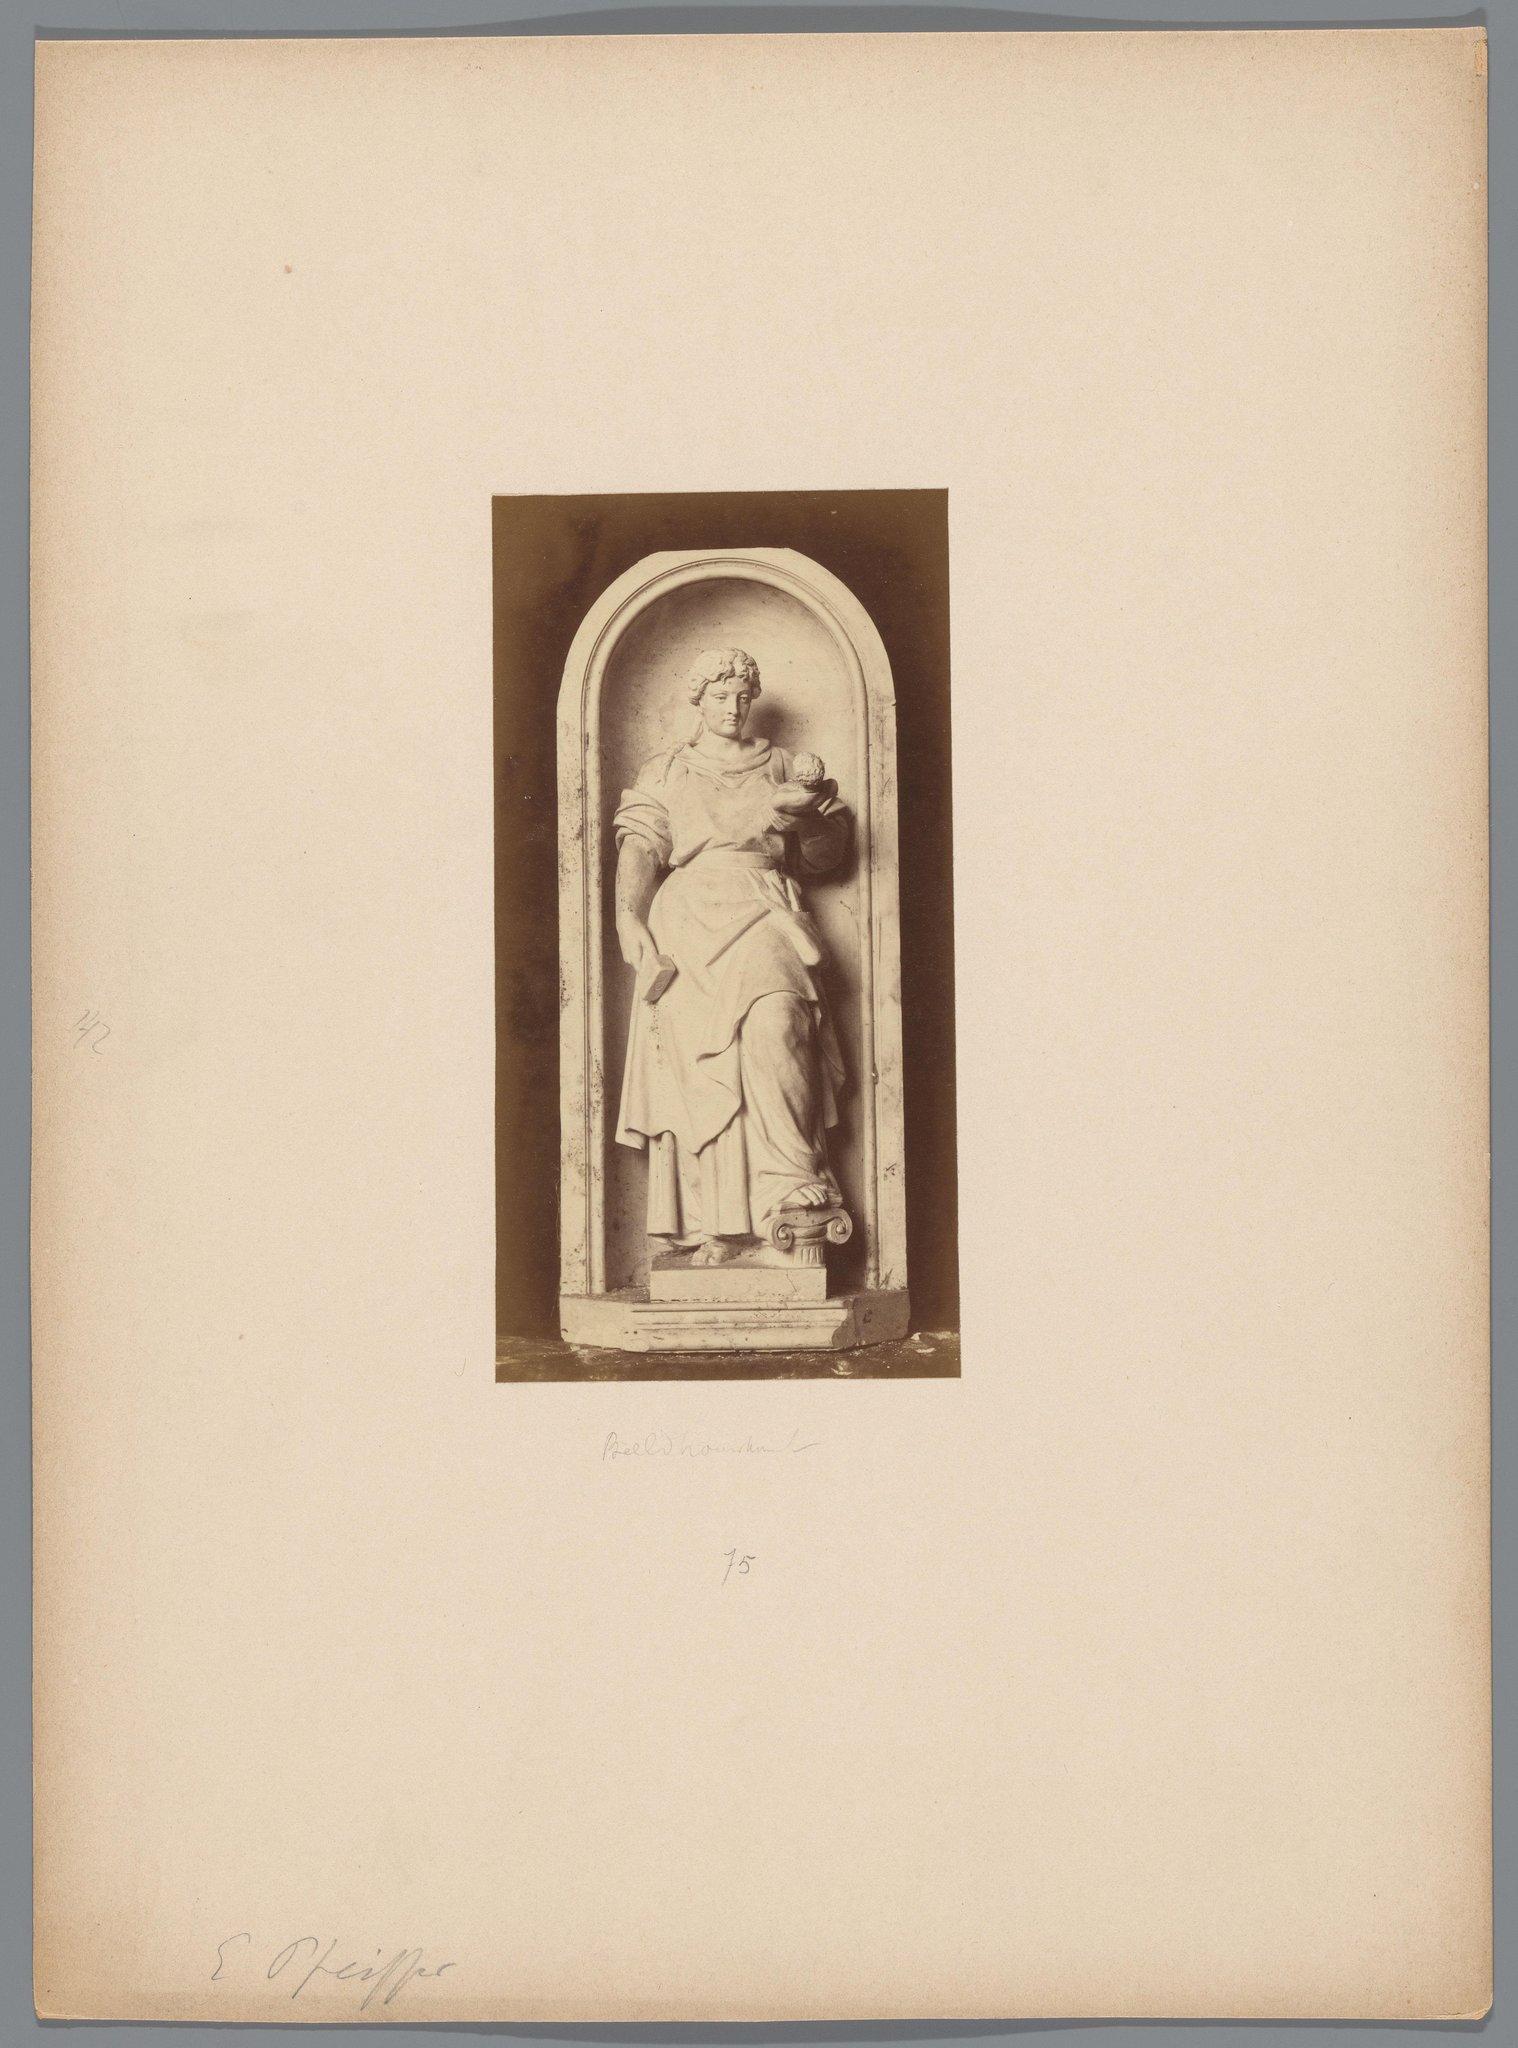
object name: print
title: Fotoreproductie van het beeldhouwwerk De Beeldhouwkunst door Ernst Pfeifer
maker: Anonymous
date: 1880-1887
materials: cardboard, paper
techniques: albumen print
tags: 'sculptura', symbolic representations, allegories and emblems ~ sculpture; 'scoltura' (ripa), piece of sculpture, reproduction of a piece of sculpture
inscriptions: collector's mark: Lugt 2228, inscription: ‘E. Pfeiffer’, inscription: ‘Beeldhouwer/ 75/ 142’